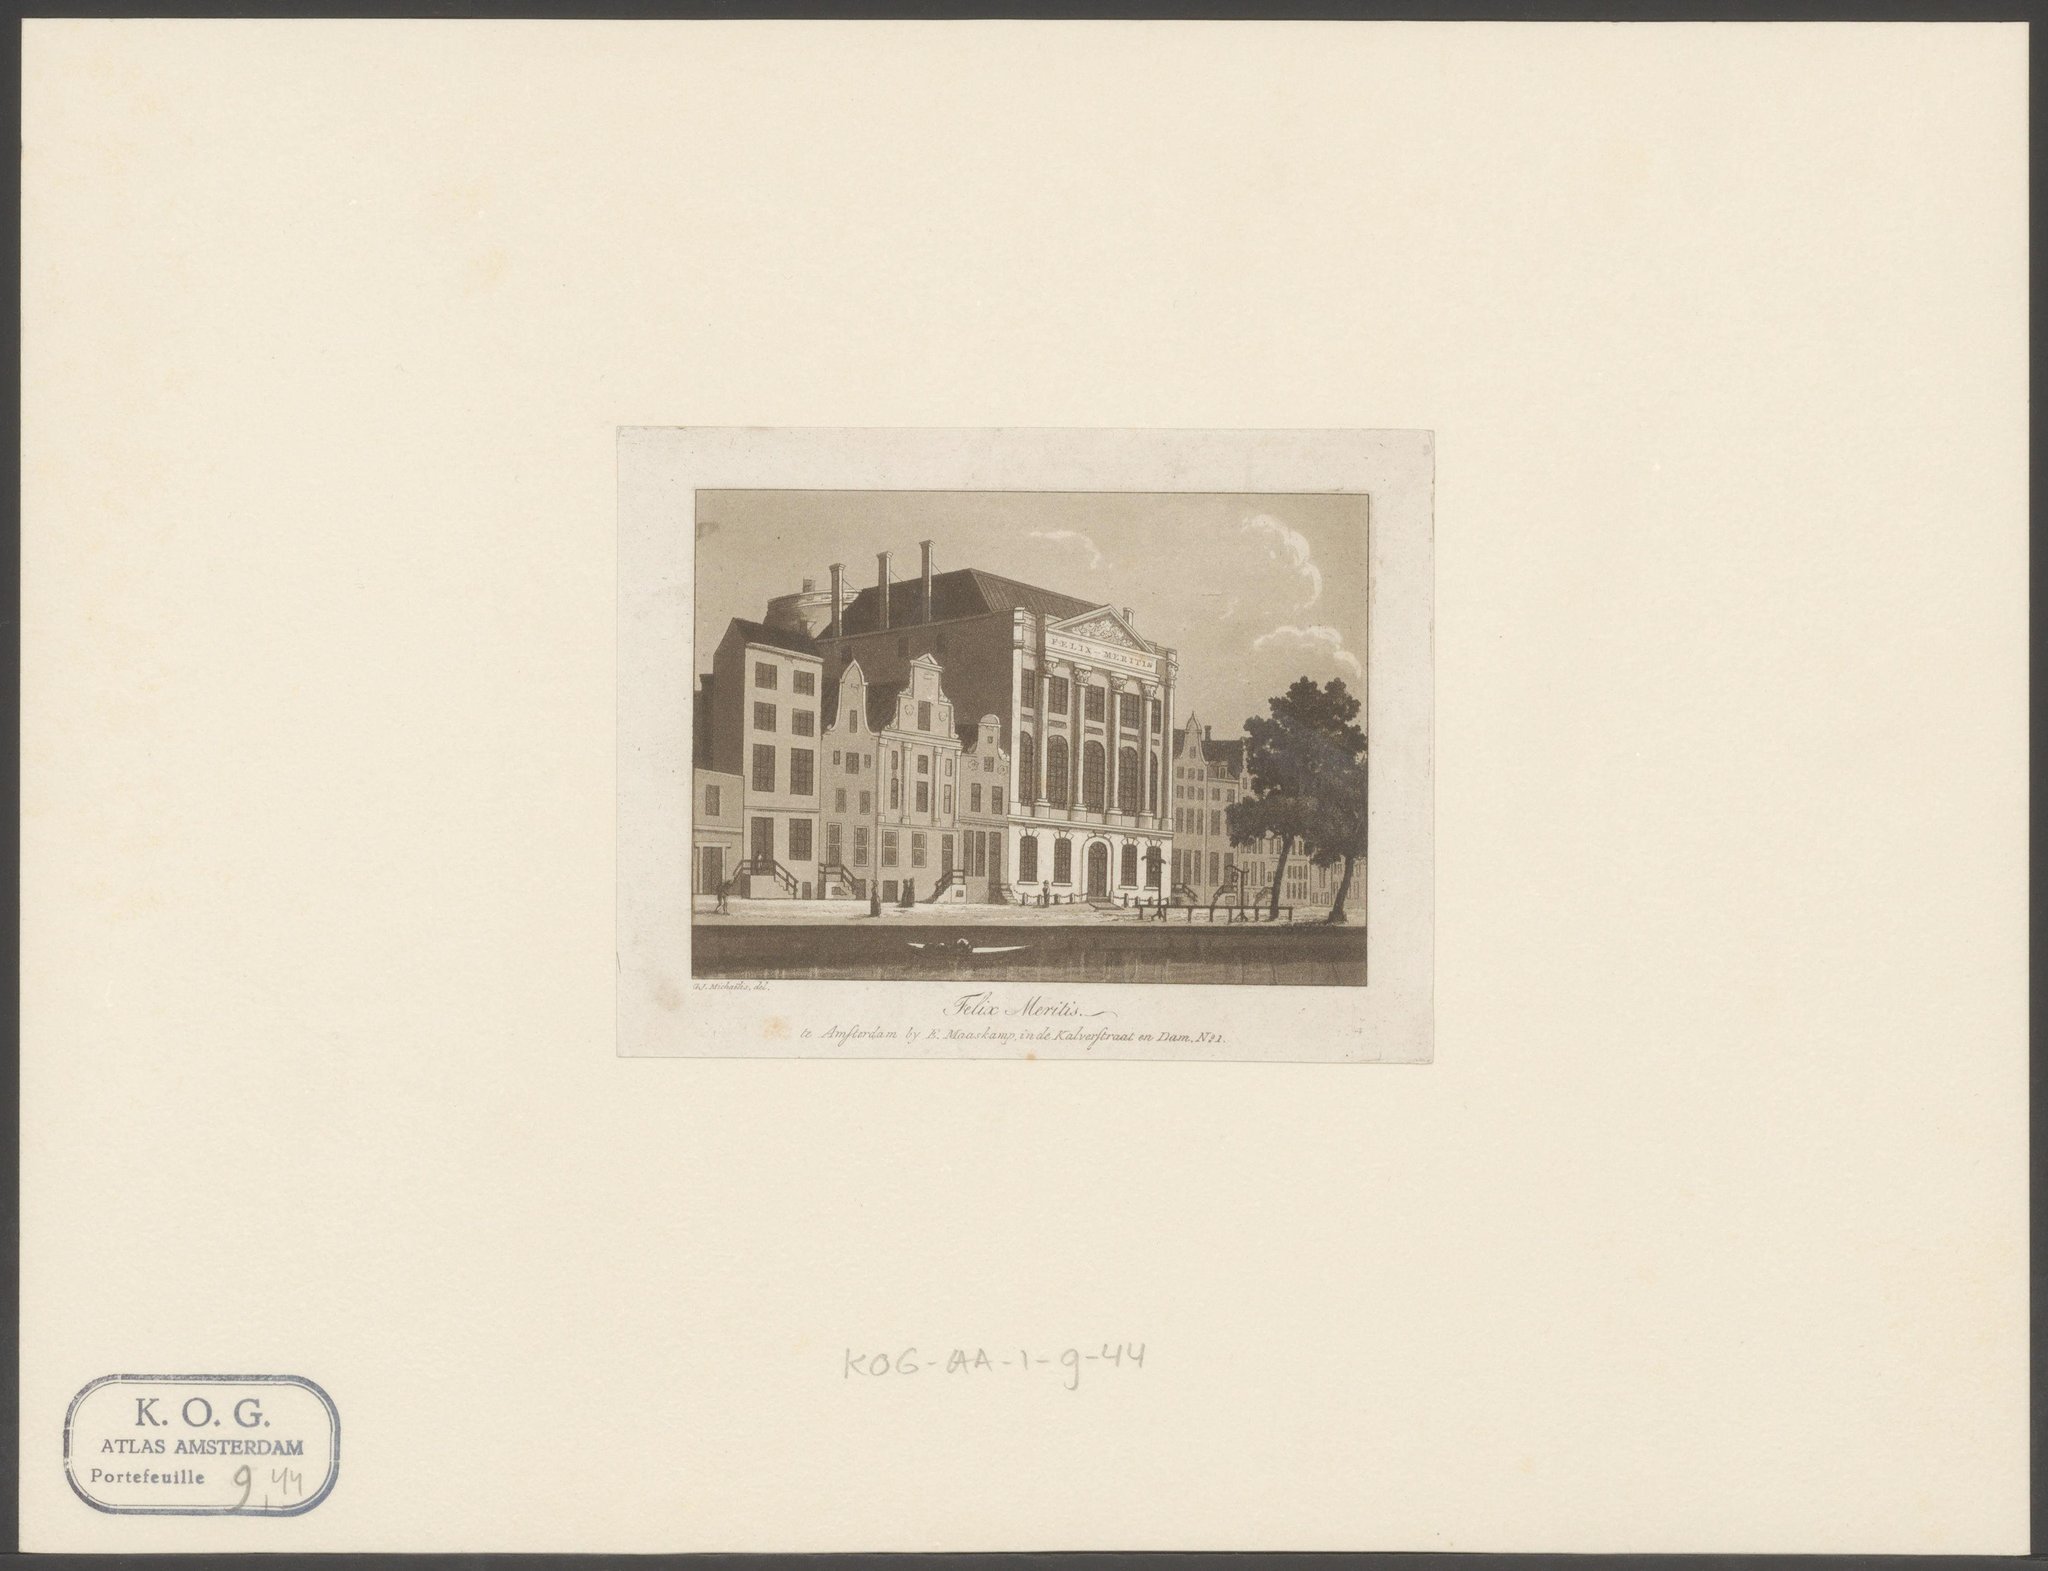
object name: print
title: Felix Meritis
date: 1812-1813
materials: paper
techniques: aquatint, etching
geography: amsterdam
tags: city-view in general; 'veduta', canal, façade (of house or building), street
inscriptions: collector's mark: ‘9,44’ Lugt 1641b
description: Onderwerpsrubriek binnen de Atlas Amsterdam: Kadijksplein, Karthuizerkerkhof, Kattegat, Kattenburg, Kapelsteeg O.Z., Enge Kerksteeg, Kerkstraat, Kinkerstraat, Kolk O.Z., Koningsplein, Kromboomsloot [Krom Boomssloot], Kostverlorenkade, Kwakersdwarspad, Kalverstraat, Keizersgracht (v.d. Brouwersgracht – Amstel), Klerensloot (Gedempte), Klimopstraat, Kloveniersburgwal, Kraansluis.